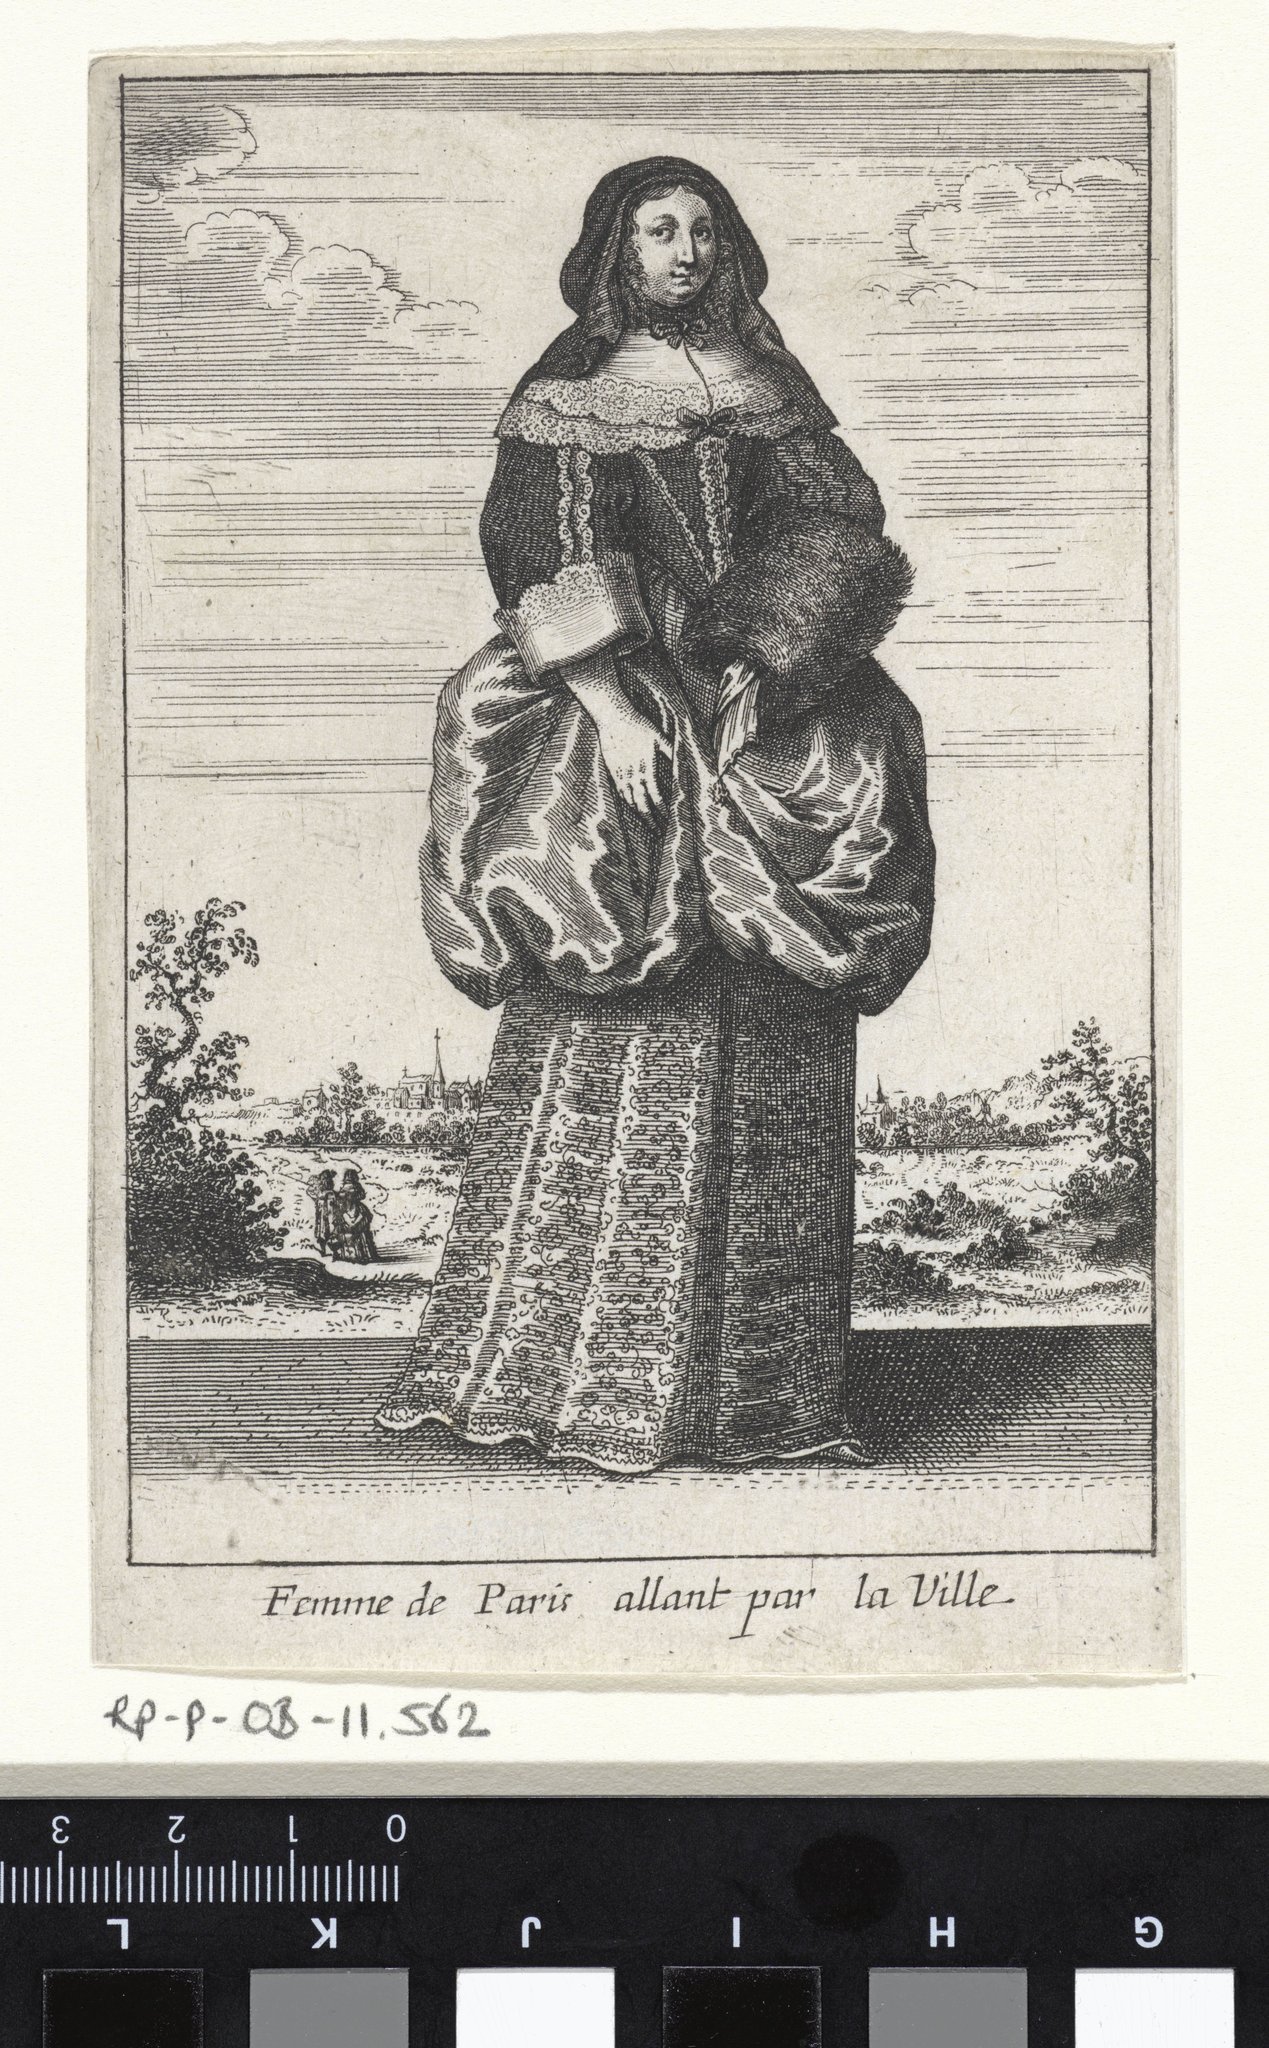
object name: costume print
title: Livre Curieux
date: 1662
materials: paper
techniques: etching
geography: paris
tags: paris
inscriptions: collector's mark: Lugt 240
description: De prent maakt deel uit van de 28-delige serie (excl. titelprent) met voorstellingen van vrouwen in verschillende klederdrachten, getiteld "Livre curieux contenant la naifue representations des habits des femmes des diverses parties du Monde (...), 1662".